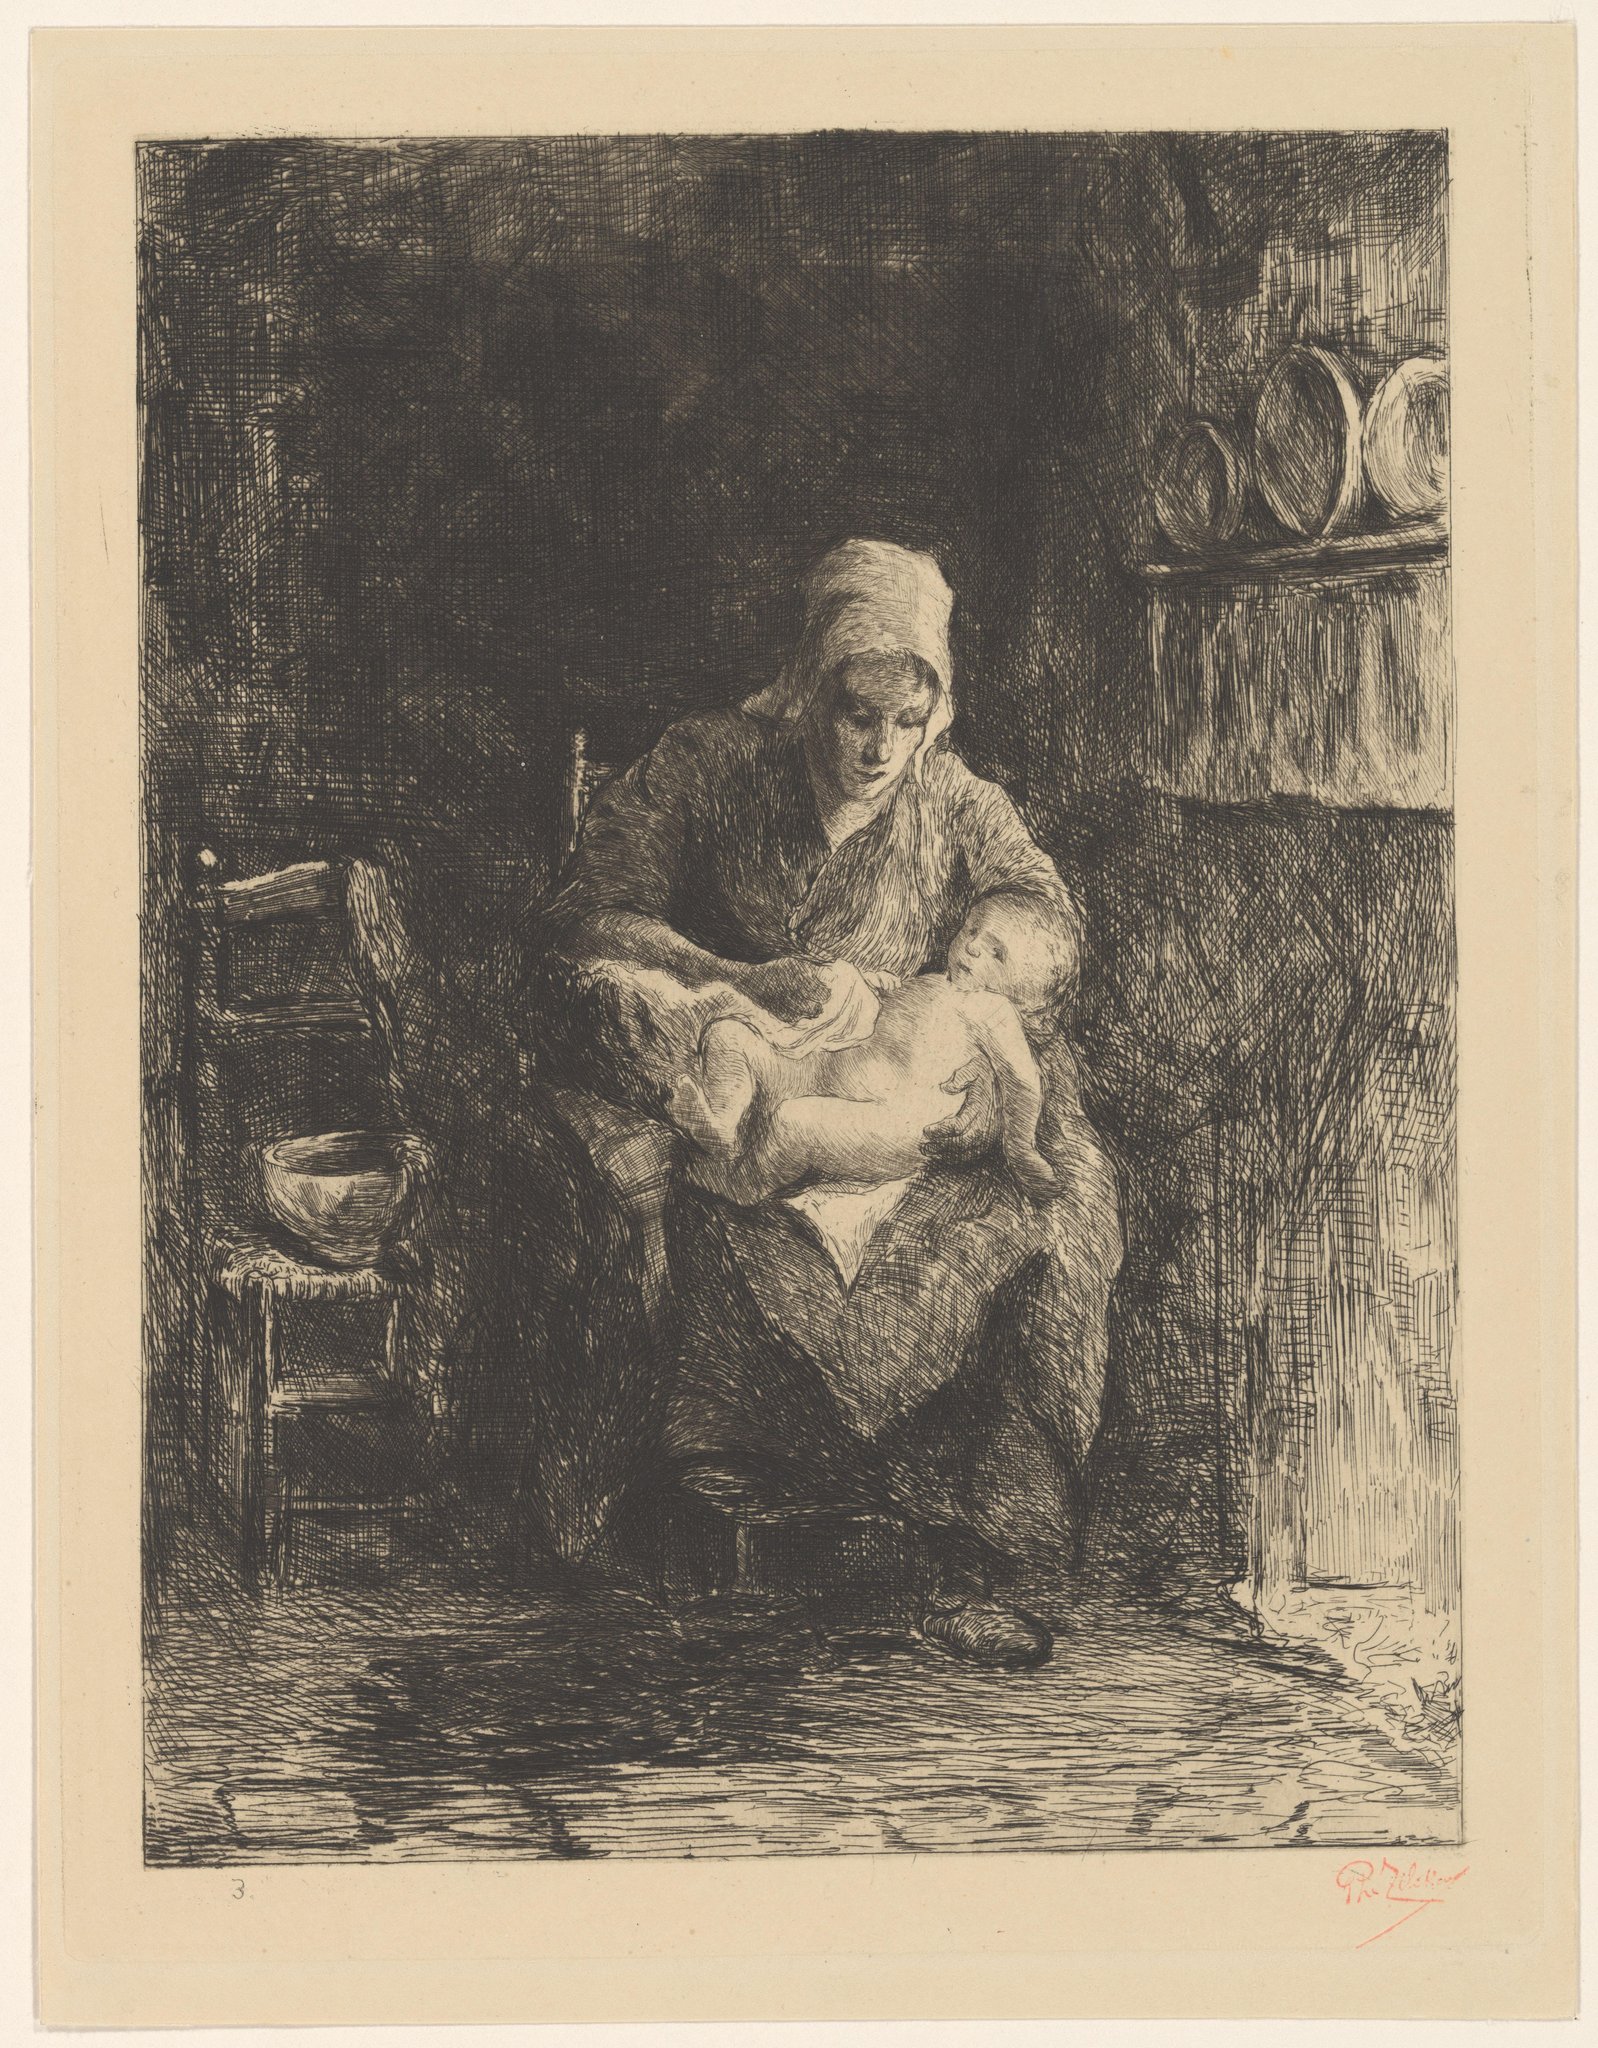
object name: print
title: Vrouw wast een kind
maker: philip zilcken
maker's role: draughtsman, painter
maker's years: 1857-1930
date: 1867-1890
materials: paper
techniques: etching, intaglio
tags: adult woman, child, hygienic care of children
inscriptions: number: ‘3’, collector's mark: Lugt 2228